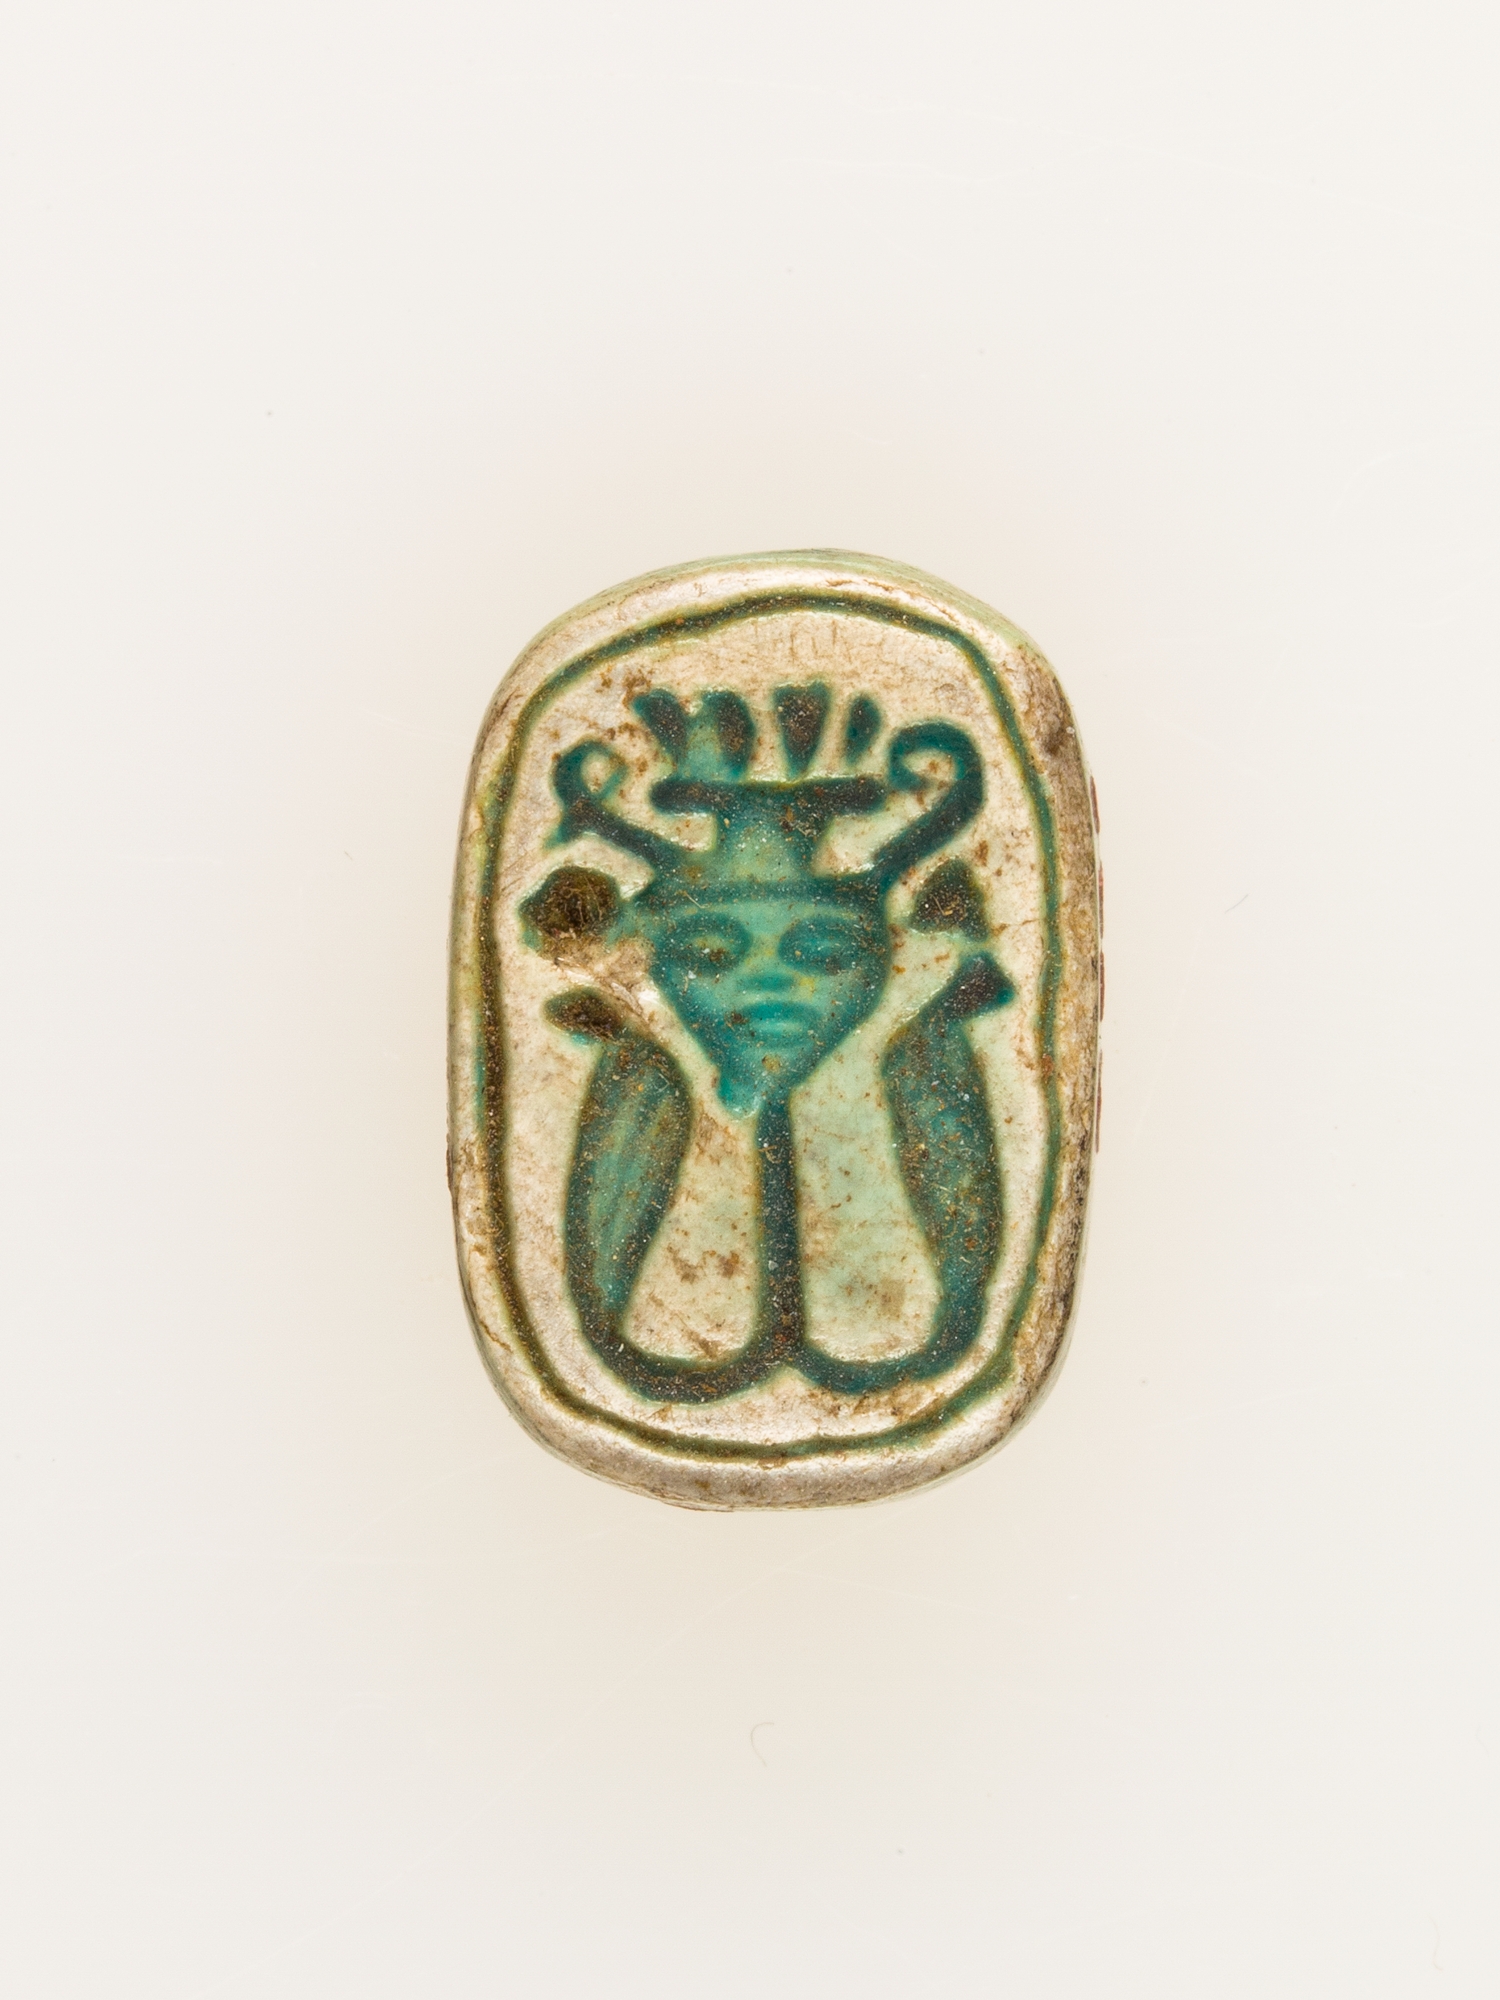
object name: scarab, hathor emblem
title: Scaraboid with an image of Hathor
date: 1550-1295 BCE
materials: faience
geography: egypt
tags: hathor,taweret,scarabs